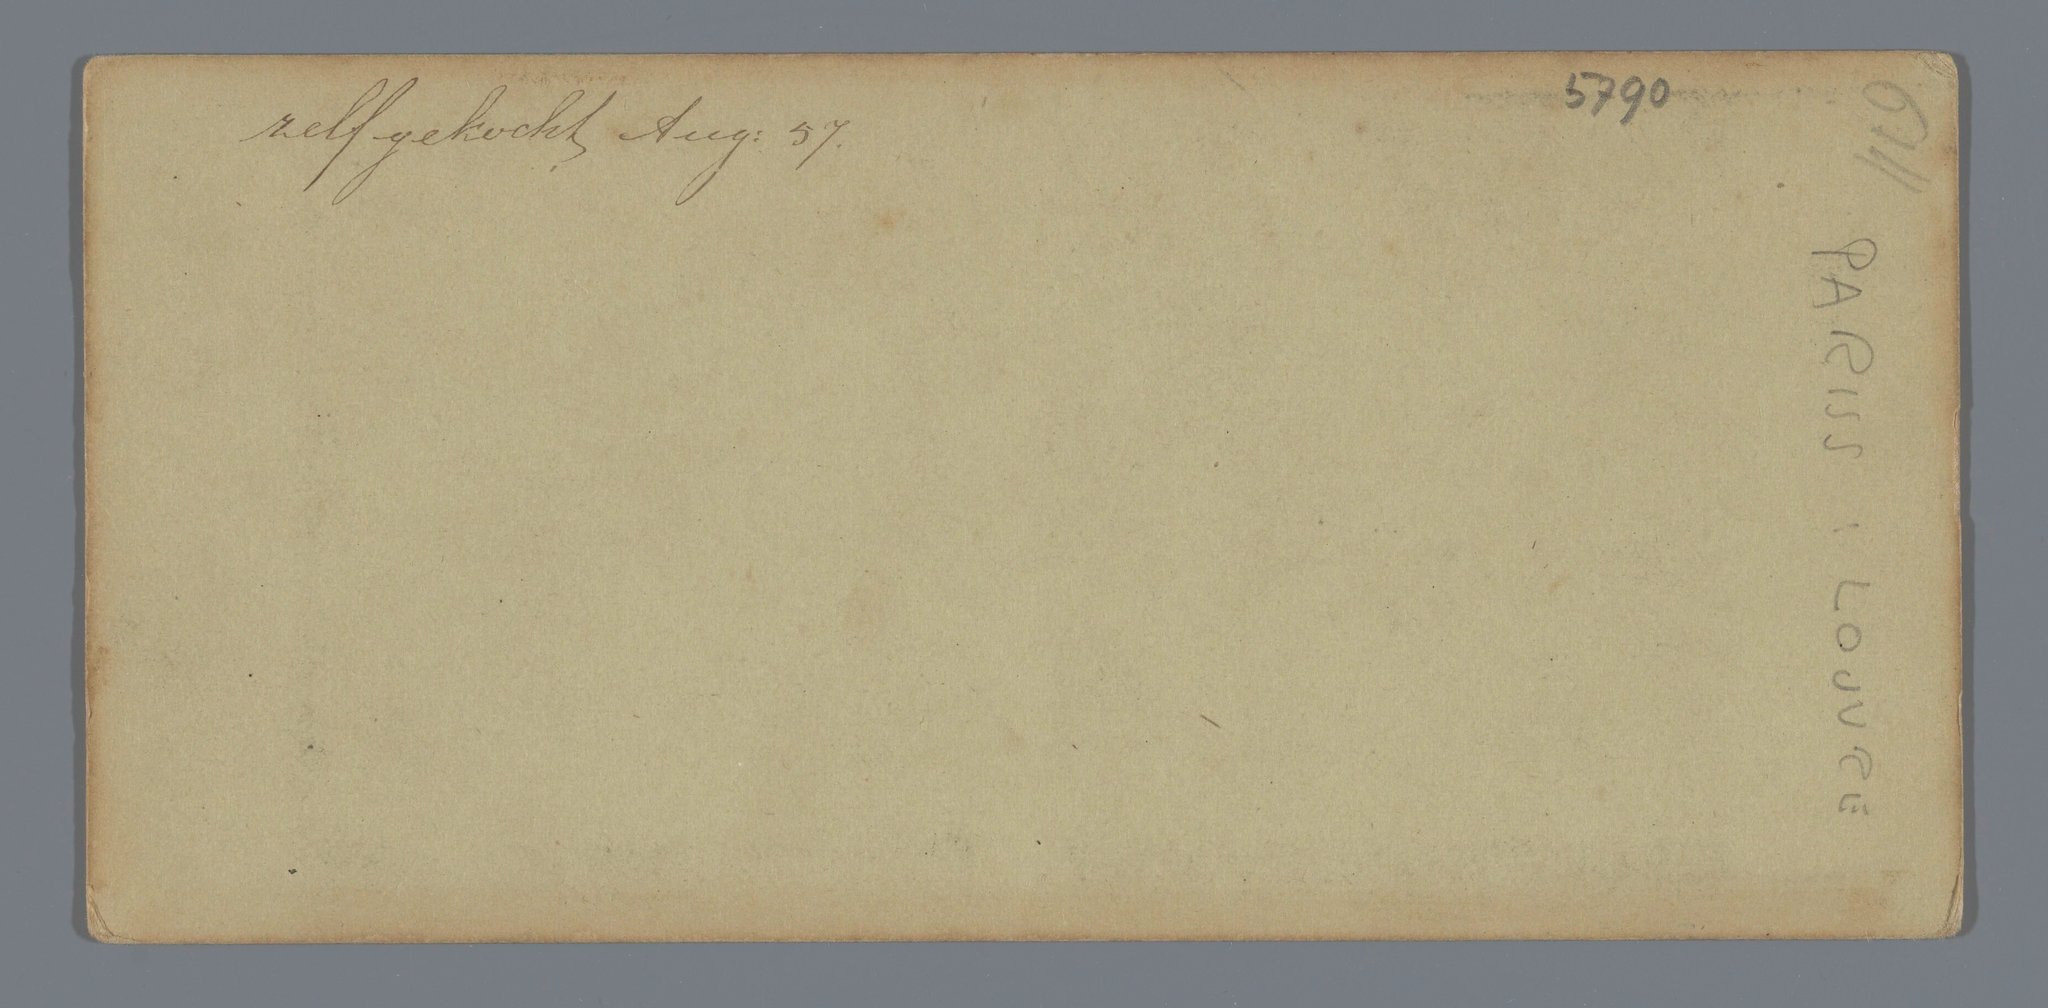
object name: stereograph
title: Gezicht op het Musée du Louvre in Parijs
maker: Anonymous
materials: cardboard, photographic support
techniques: albumen print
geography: paris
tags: permanent exhibition, museum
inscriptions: inscription: ‘zelf gekocht Aug : 57’, inscription: ‘614 Parijs : Louvre’